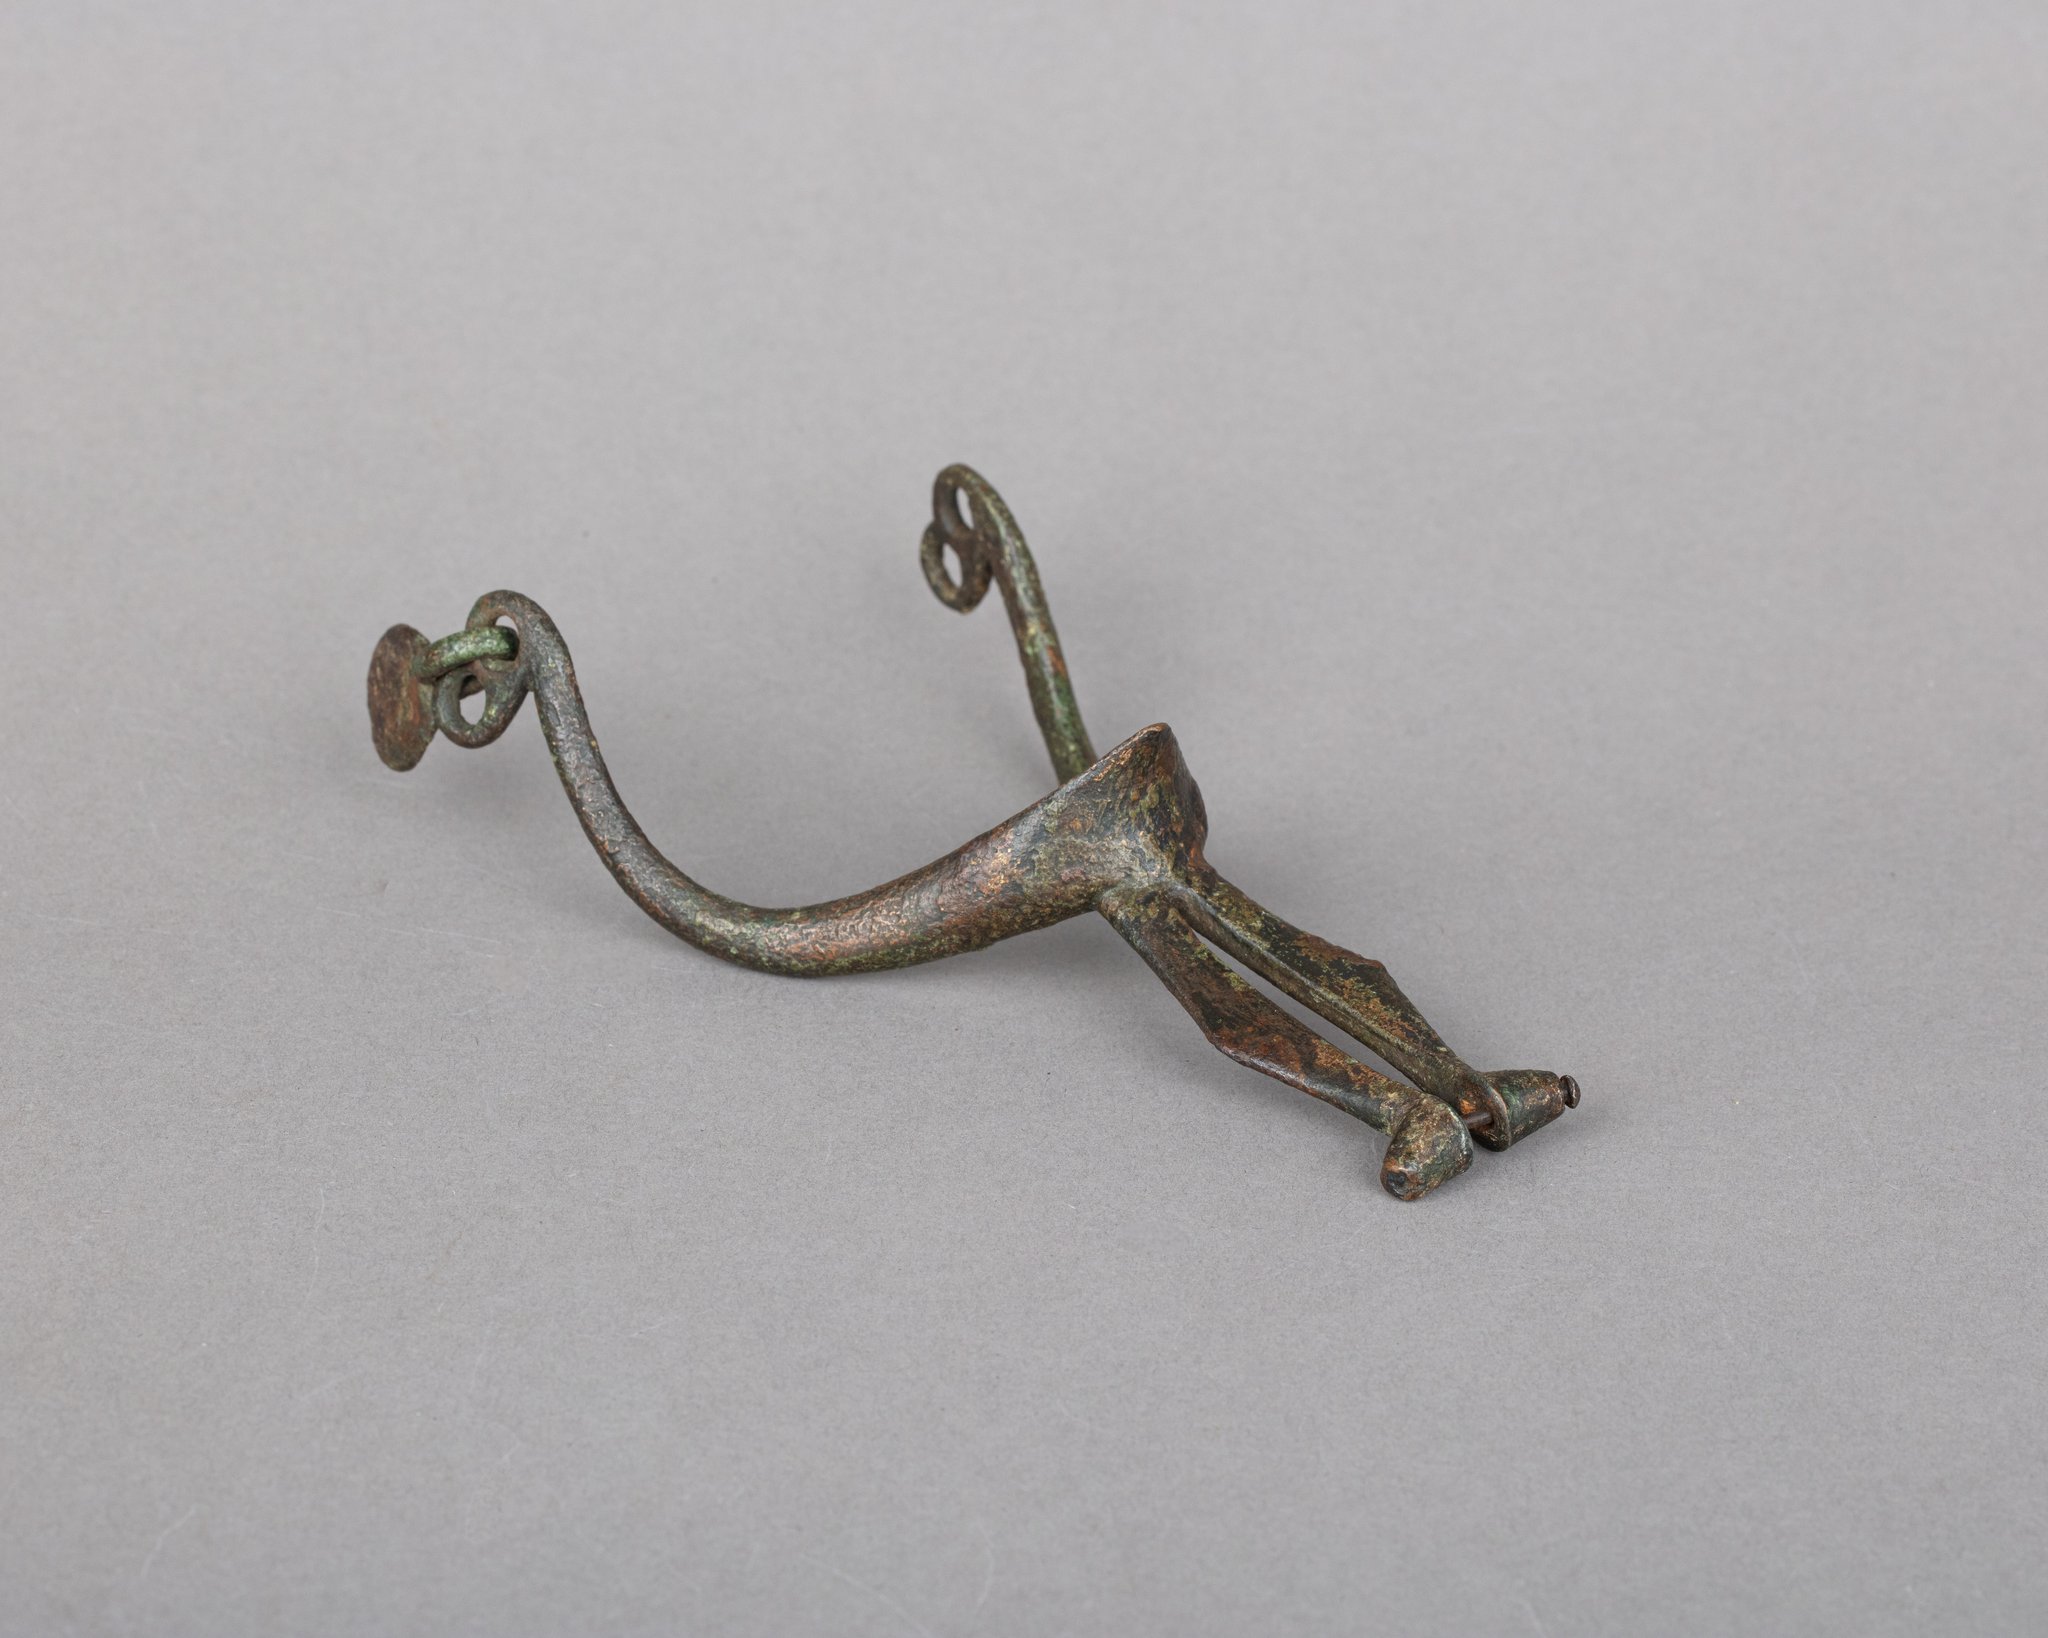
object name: spur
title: Rowel Spur (Right)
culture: french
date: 1351-1400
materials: copper alloy, gold, iron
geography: france